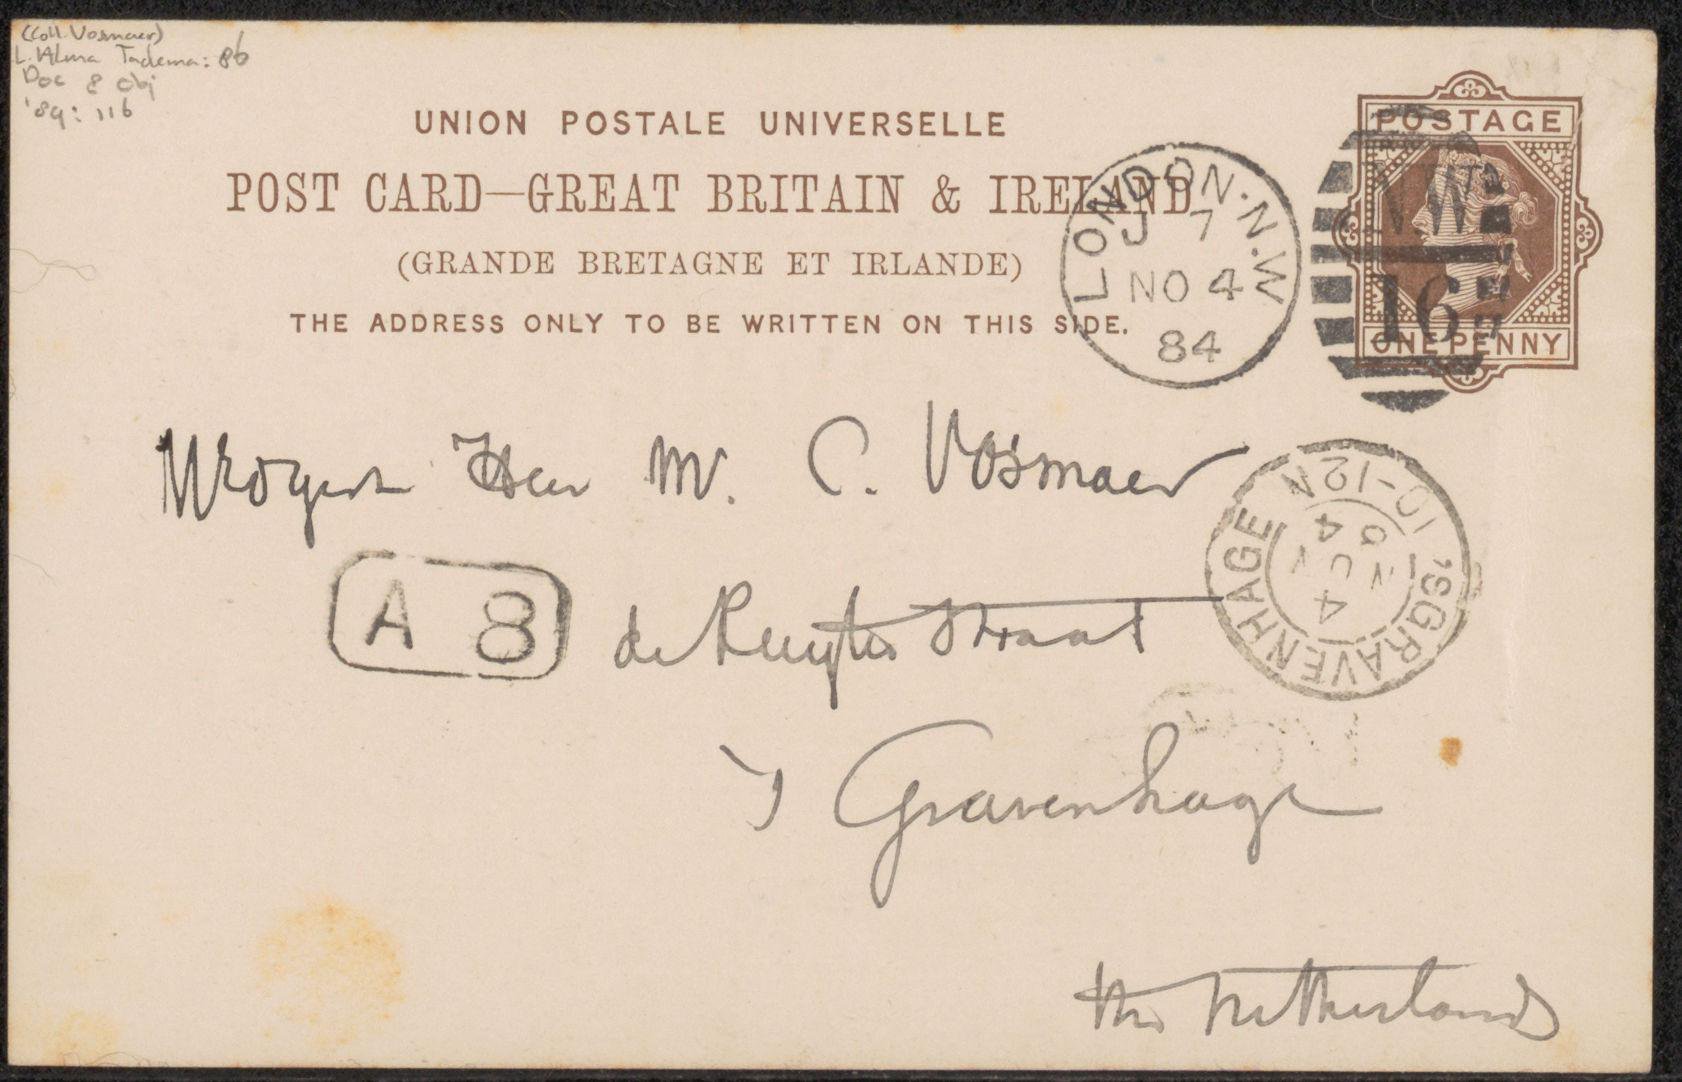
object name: postcard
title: Briefkaart aan Carel Vosmaer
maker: lourens alma tadema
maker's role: draughtsman, print maker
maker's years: 1836-1912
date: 1884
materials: cardboard, ink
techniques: pen, writing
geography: london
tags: carel vosmaer